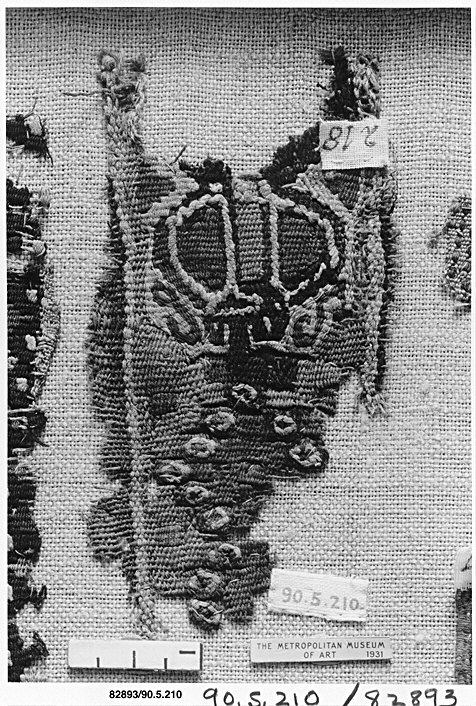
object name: textile fragment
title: Fragment of a Band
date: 501-700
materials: linen, wool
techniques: weave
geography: egypt